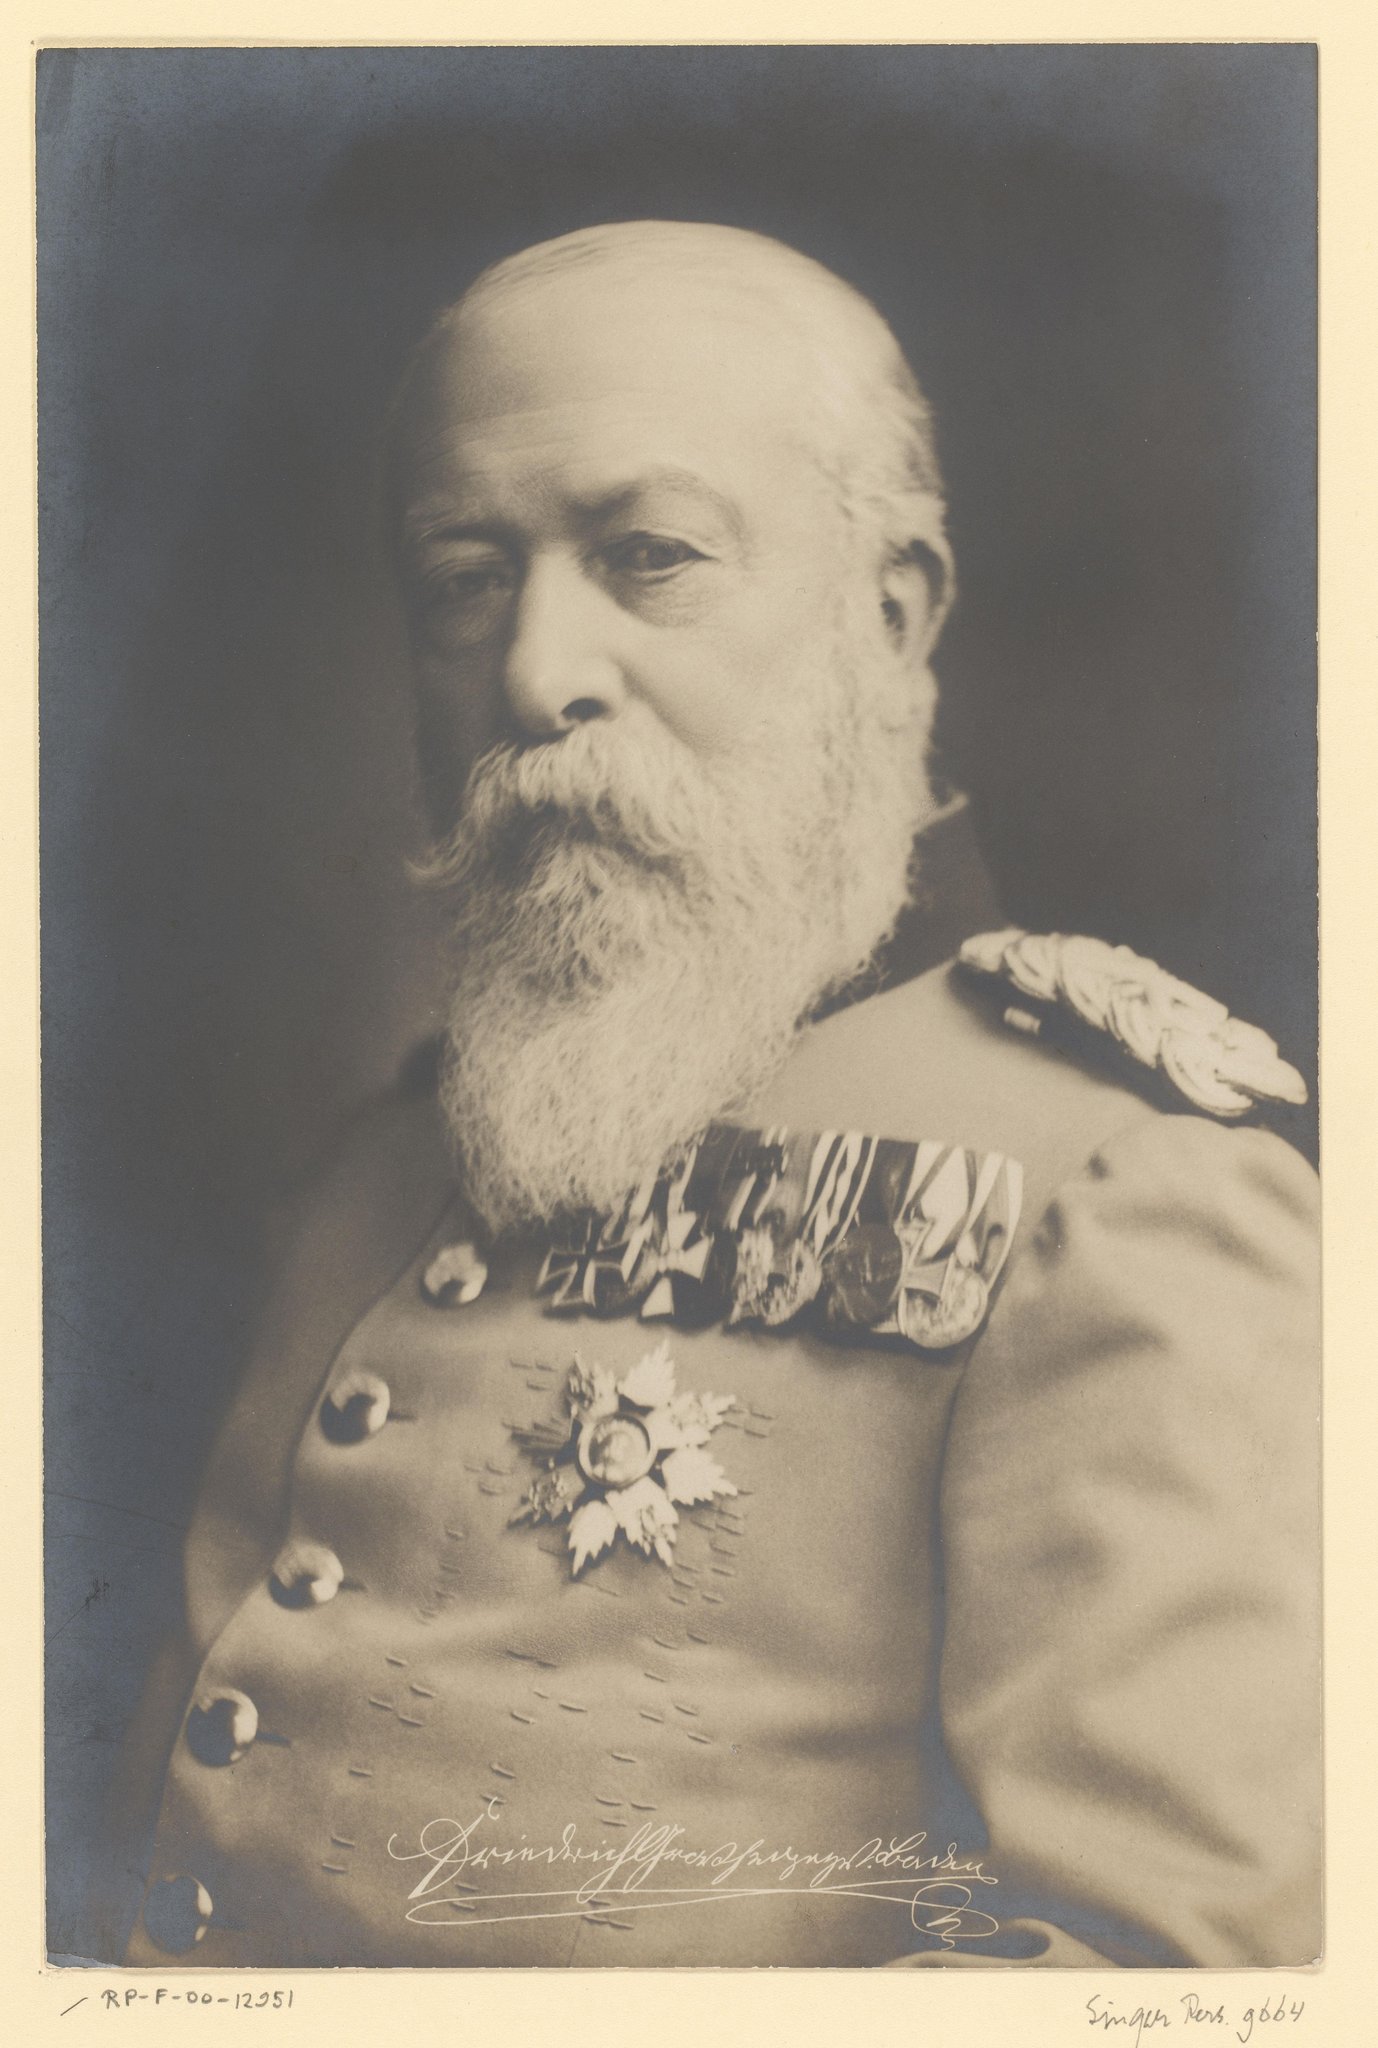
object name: photograph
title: Portret van Frederik I, groothertog van Baden, in militair uniform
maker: Anonymous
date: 1900-1907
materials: paper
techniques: gelatin silver print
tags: historical persons, other sovereign (with title)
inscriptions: signature: ‘Friedrich Grossherzog v. Baden’